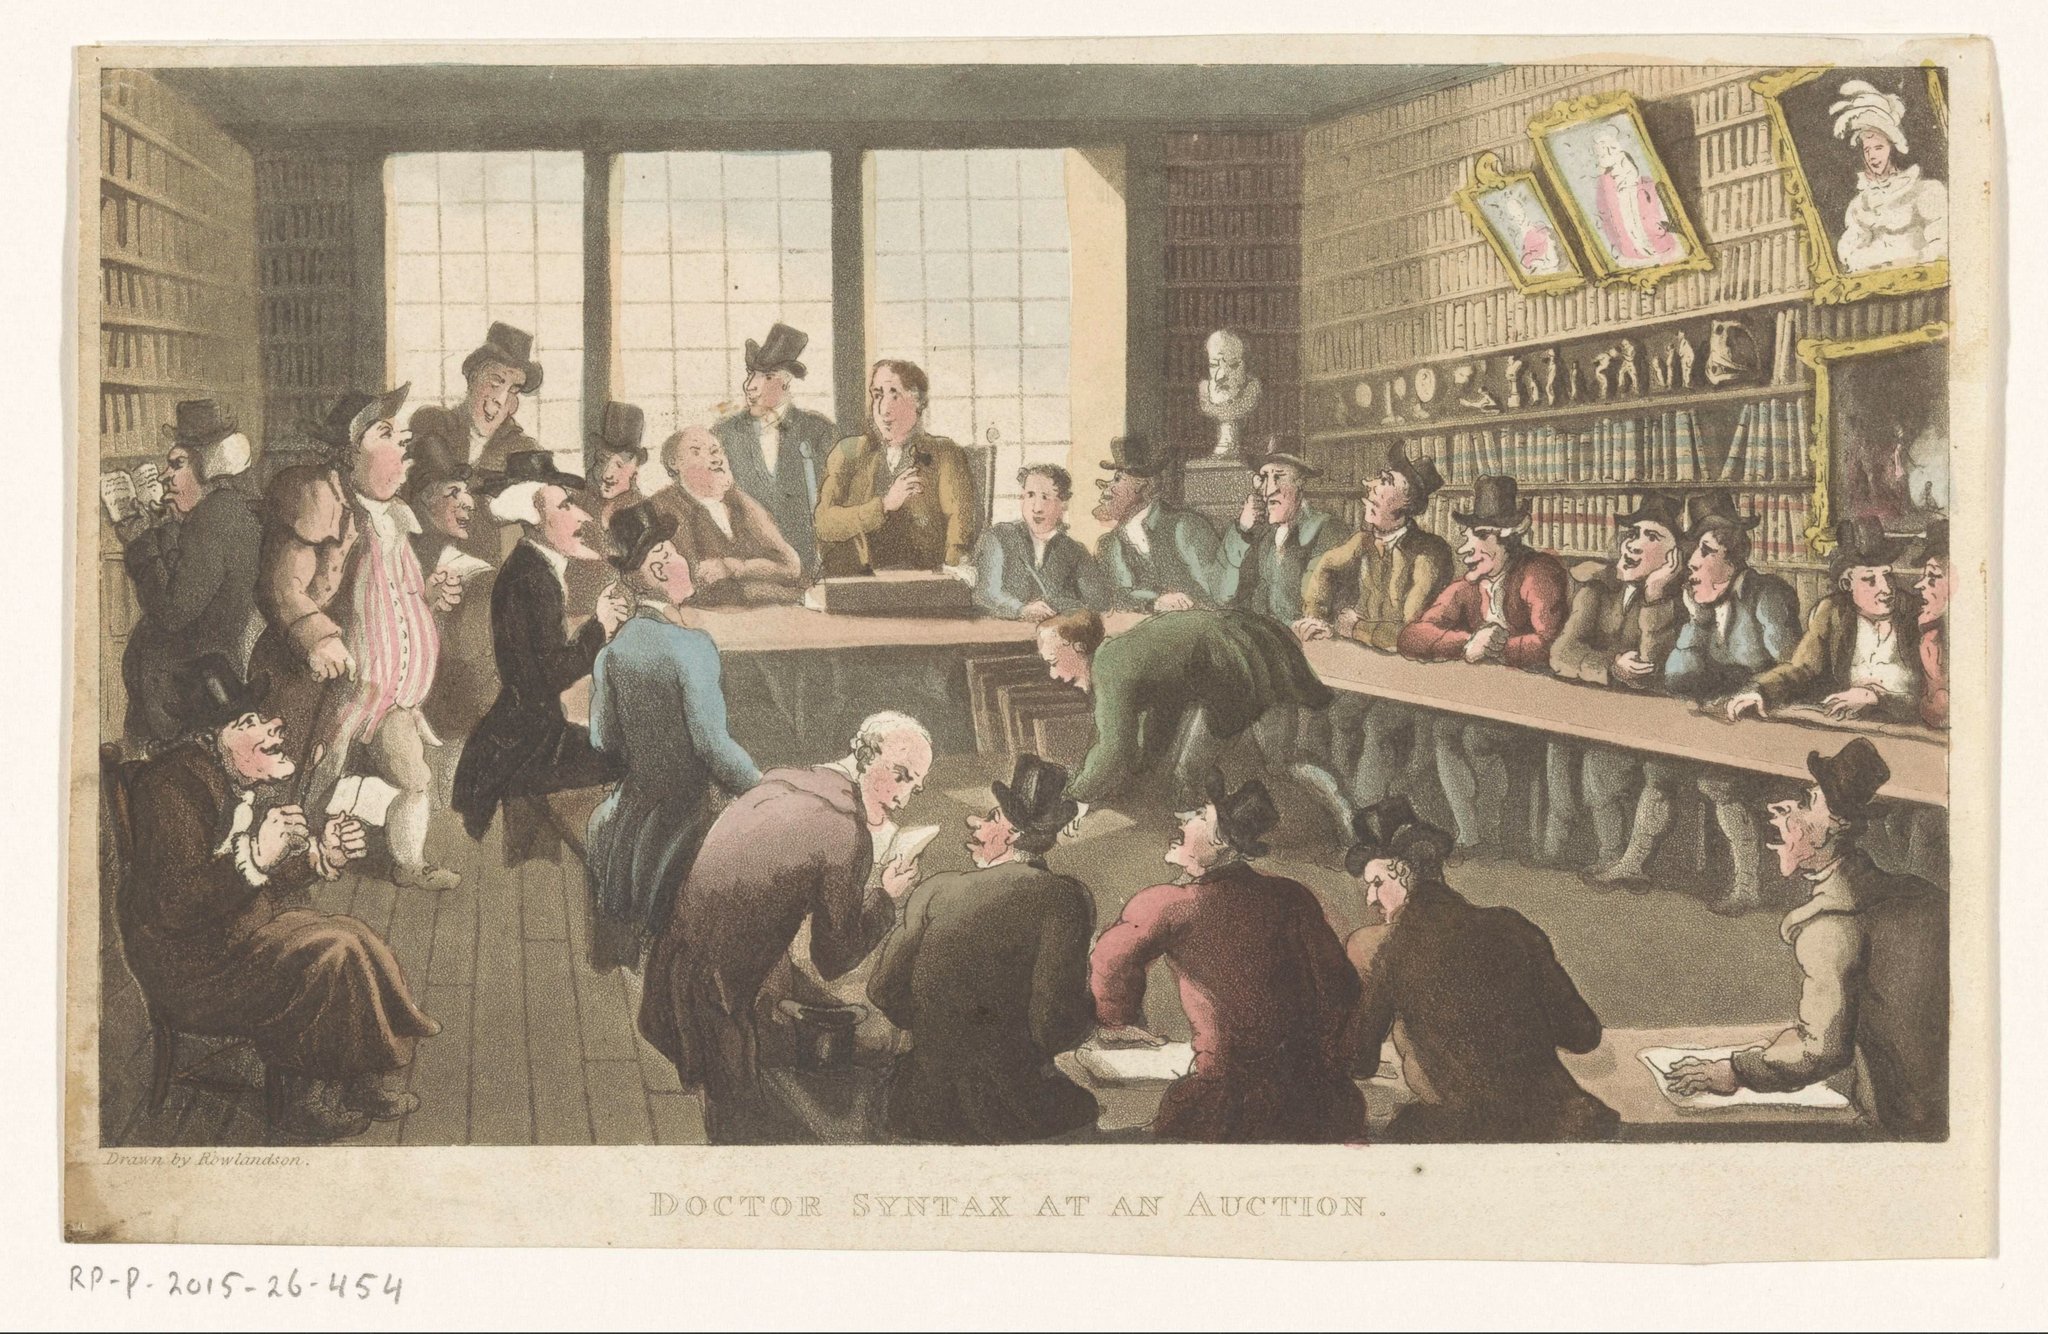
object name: print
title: Doctor Syntax at an Auction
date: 1823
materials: paper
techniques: aquatint, etching, hand coloring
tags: art sale, auction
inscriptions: collector's mark: Lugt 4780, collector's mark: Lugt 2228, collector's mark: Lugt 4779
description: Een veilingzaal met voor het raam een tafel met de veilinghouder, de kopers staan in de zaal of zitten aan tafels. Tegen de wanden boekenkasten en enkele beelden en schilderijen.